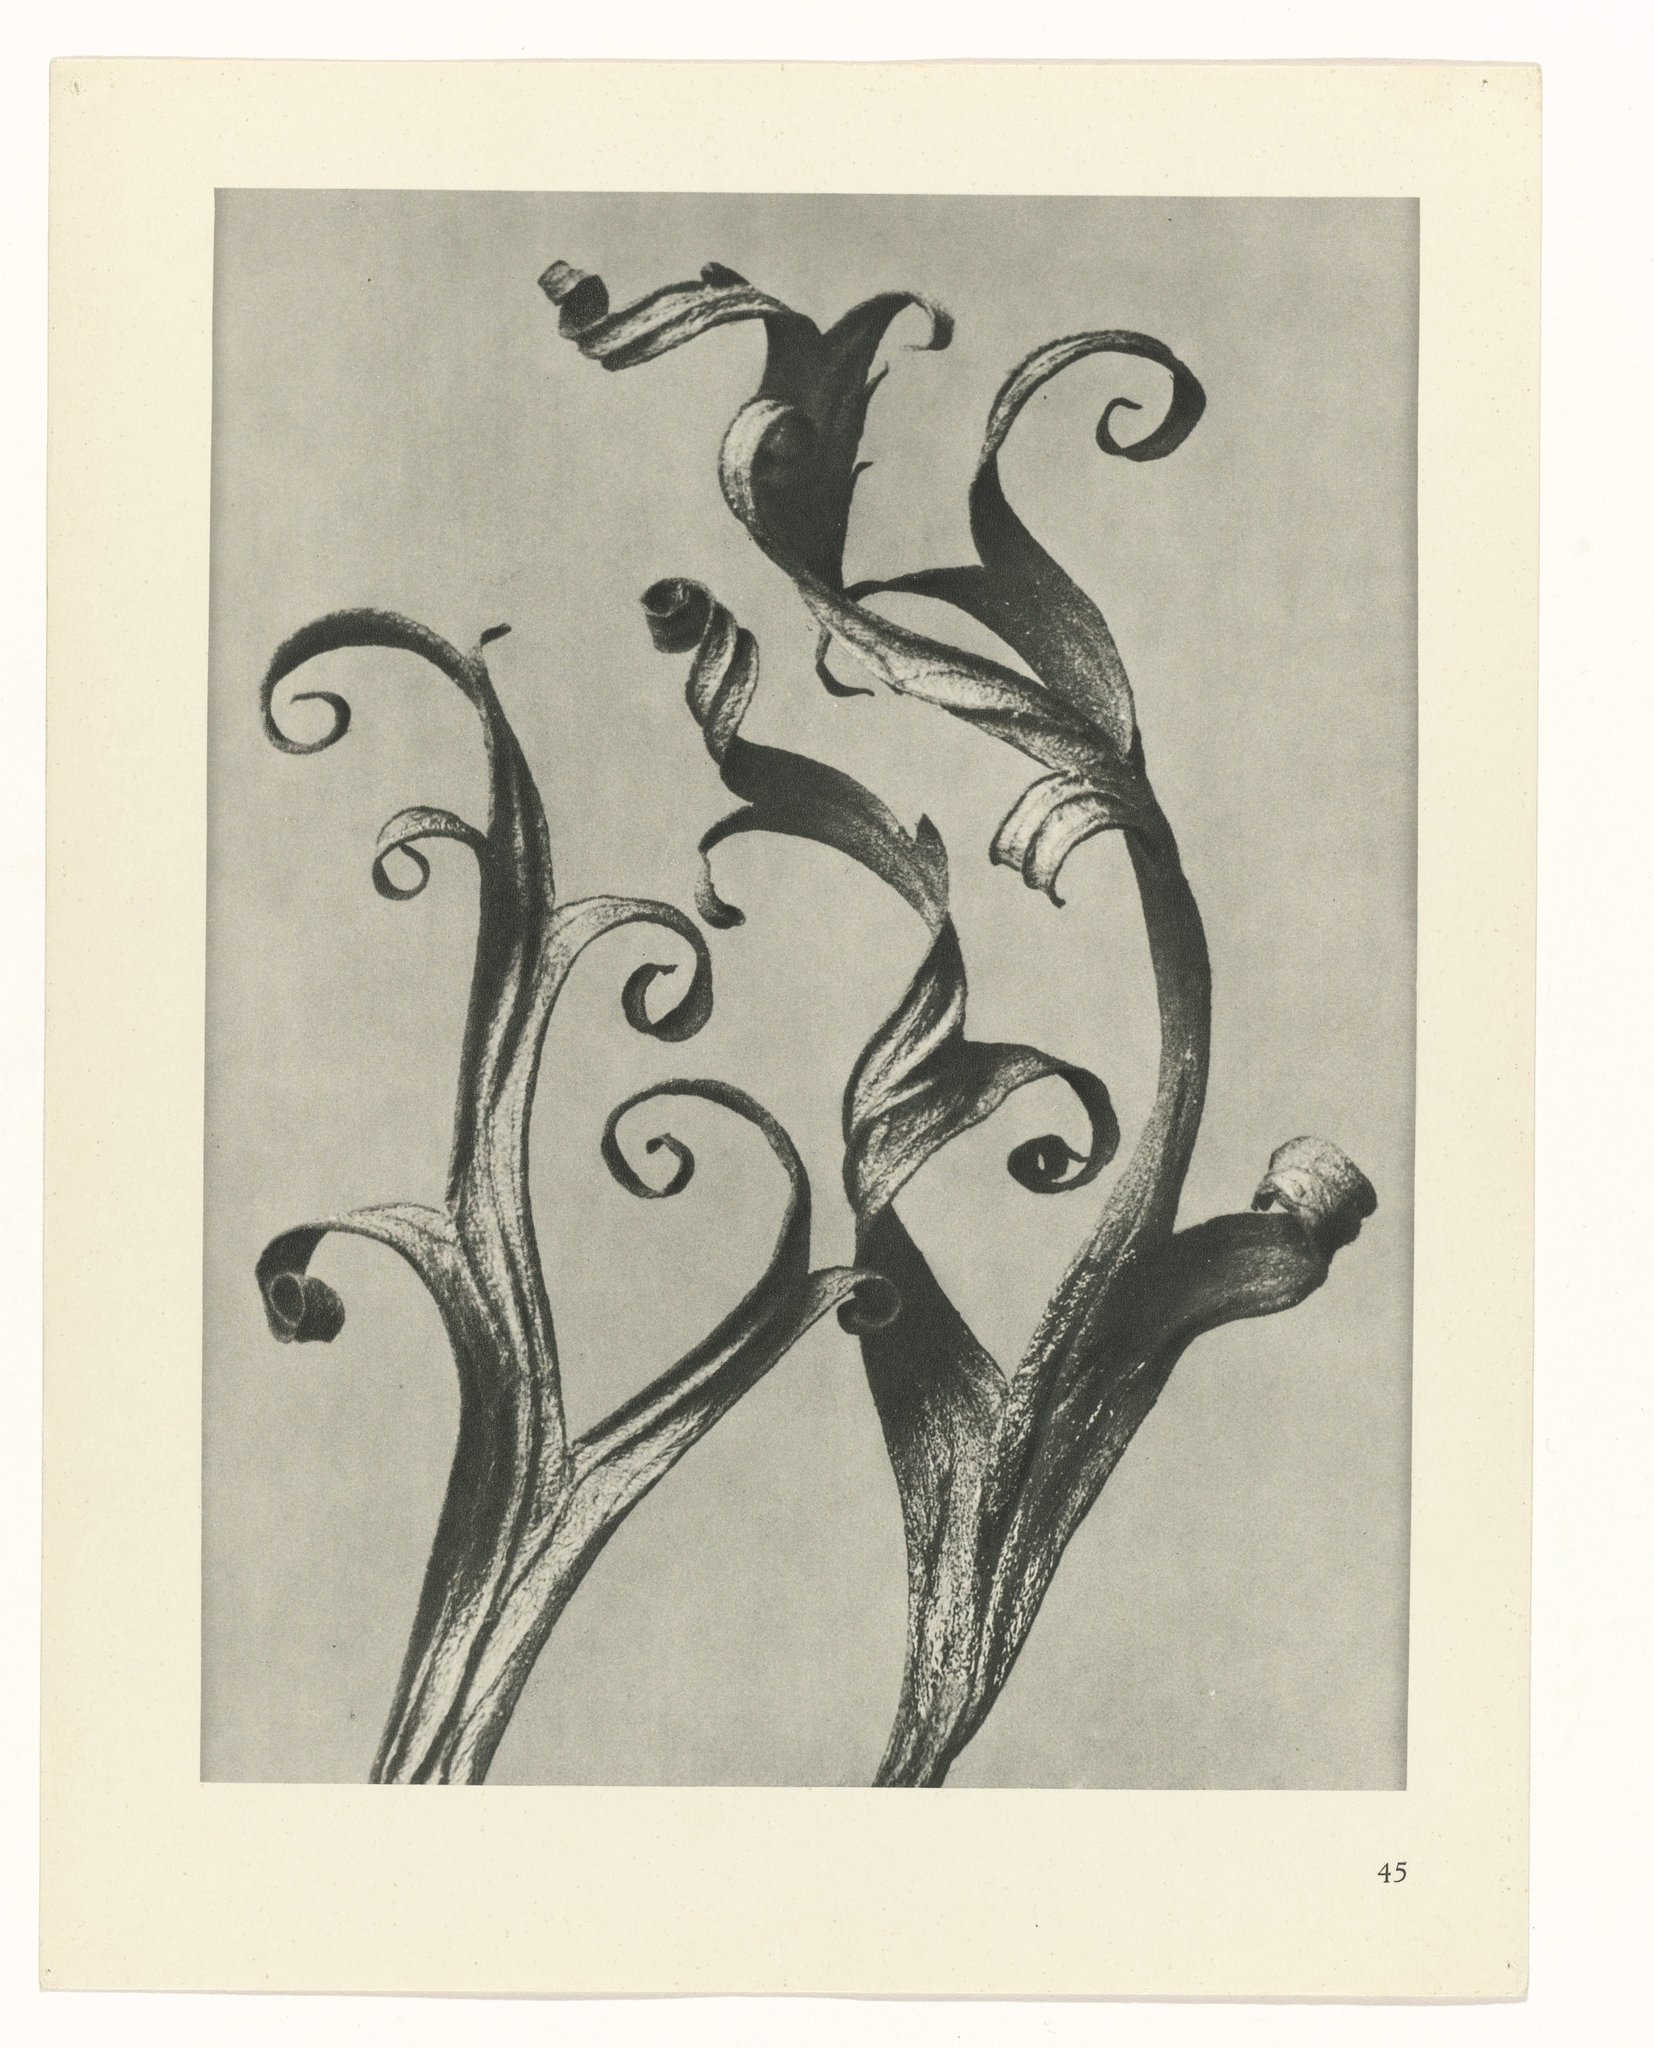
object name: photograph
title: Urformen der Kunst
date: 1928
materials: ink, paper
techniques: rotogravure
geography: berlin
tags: plants (in general)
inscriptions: number: ‘45’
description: facher Vergrößerung. Afkomstig uit losbladige uitgave.